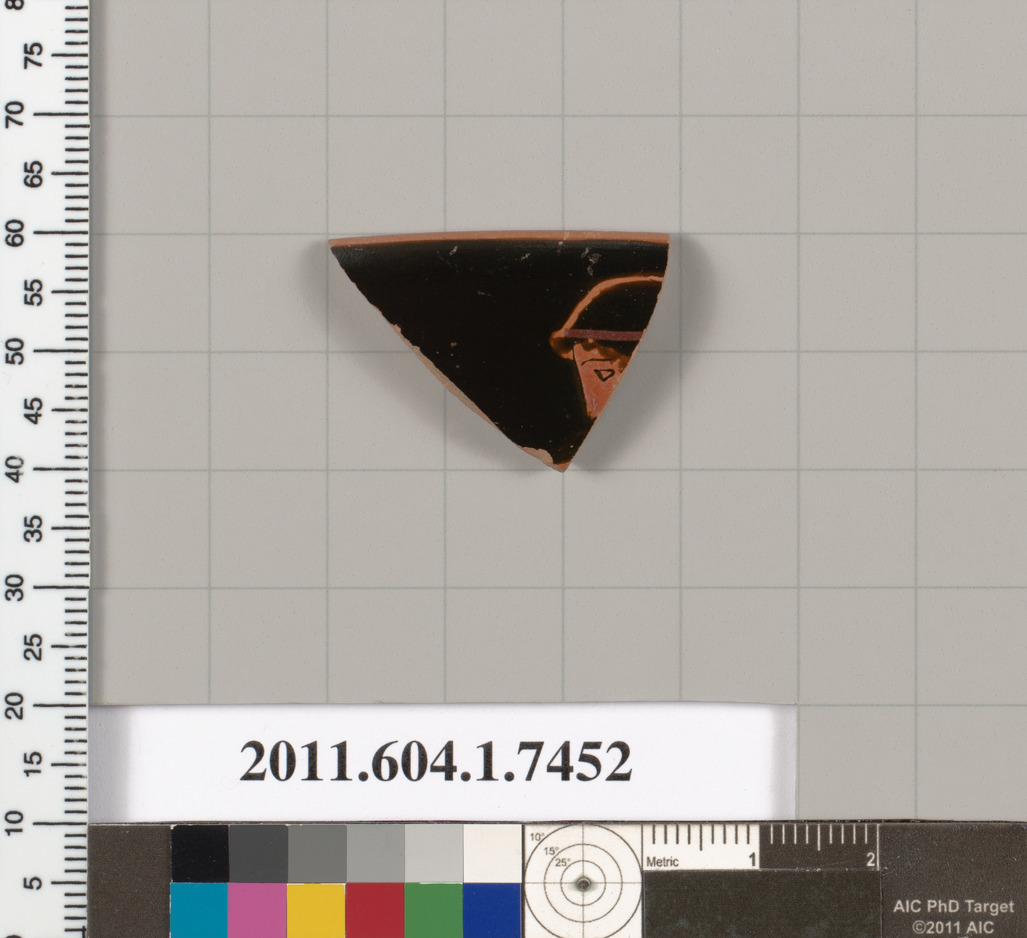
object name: kylix fragment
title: Terracotta rim fragment of a kylix (drinking cup)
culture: greek, attic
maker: hermonax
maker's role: artist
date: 470-460 BCE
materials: terracotta